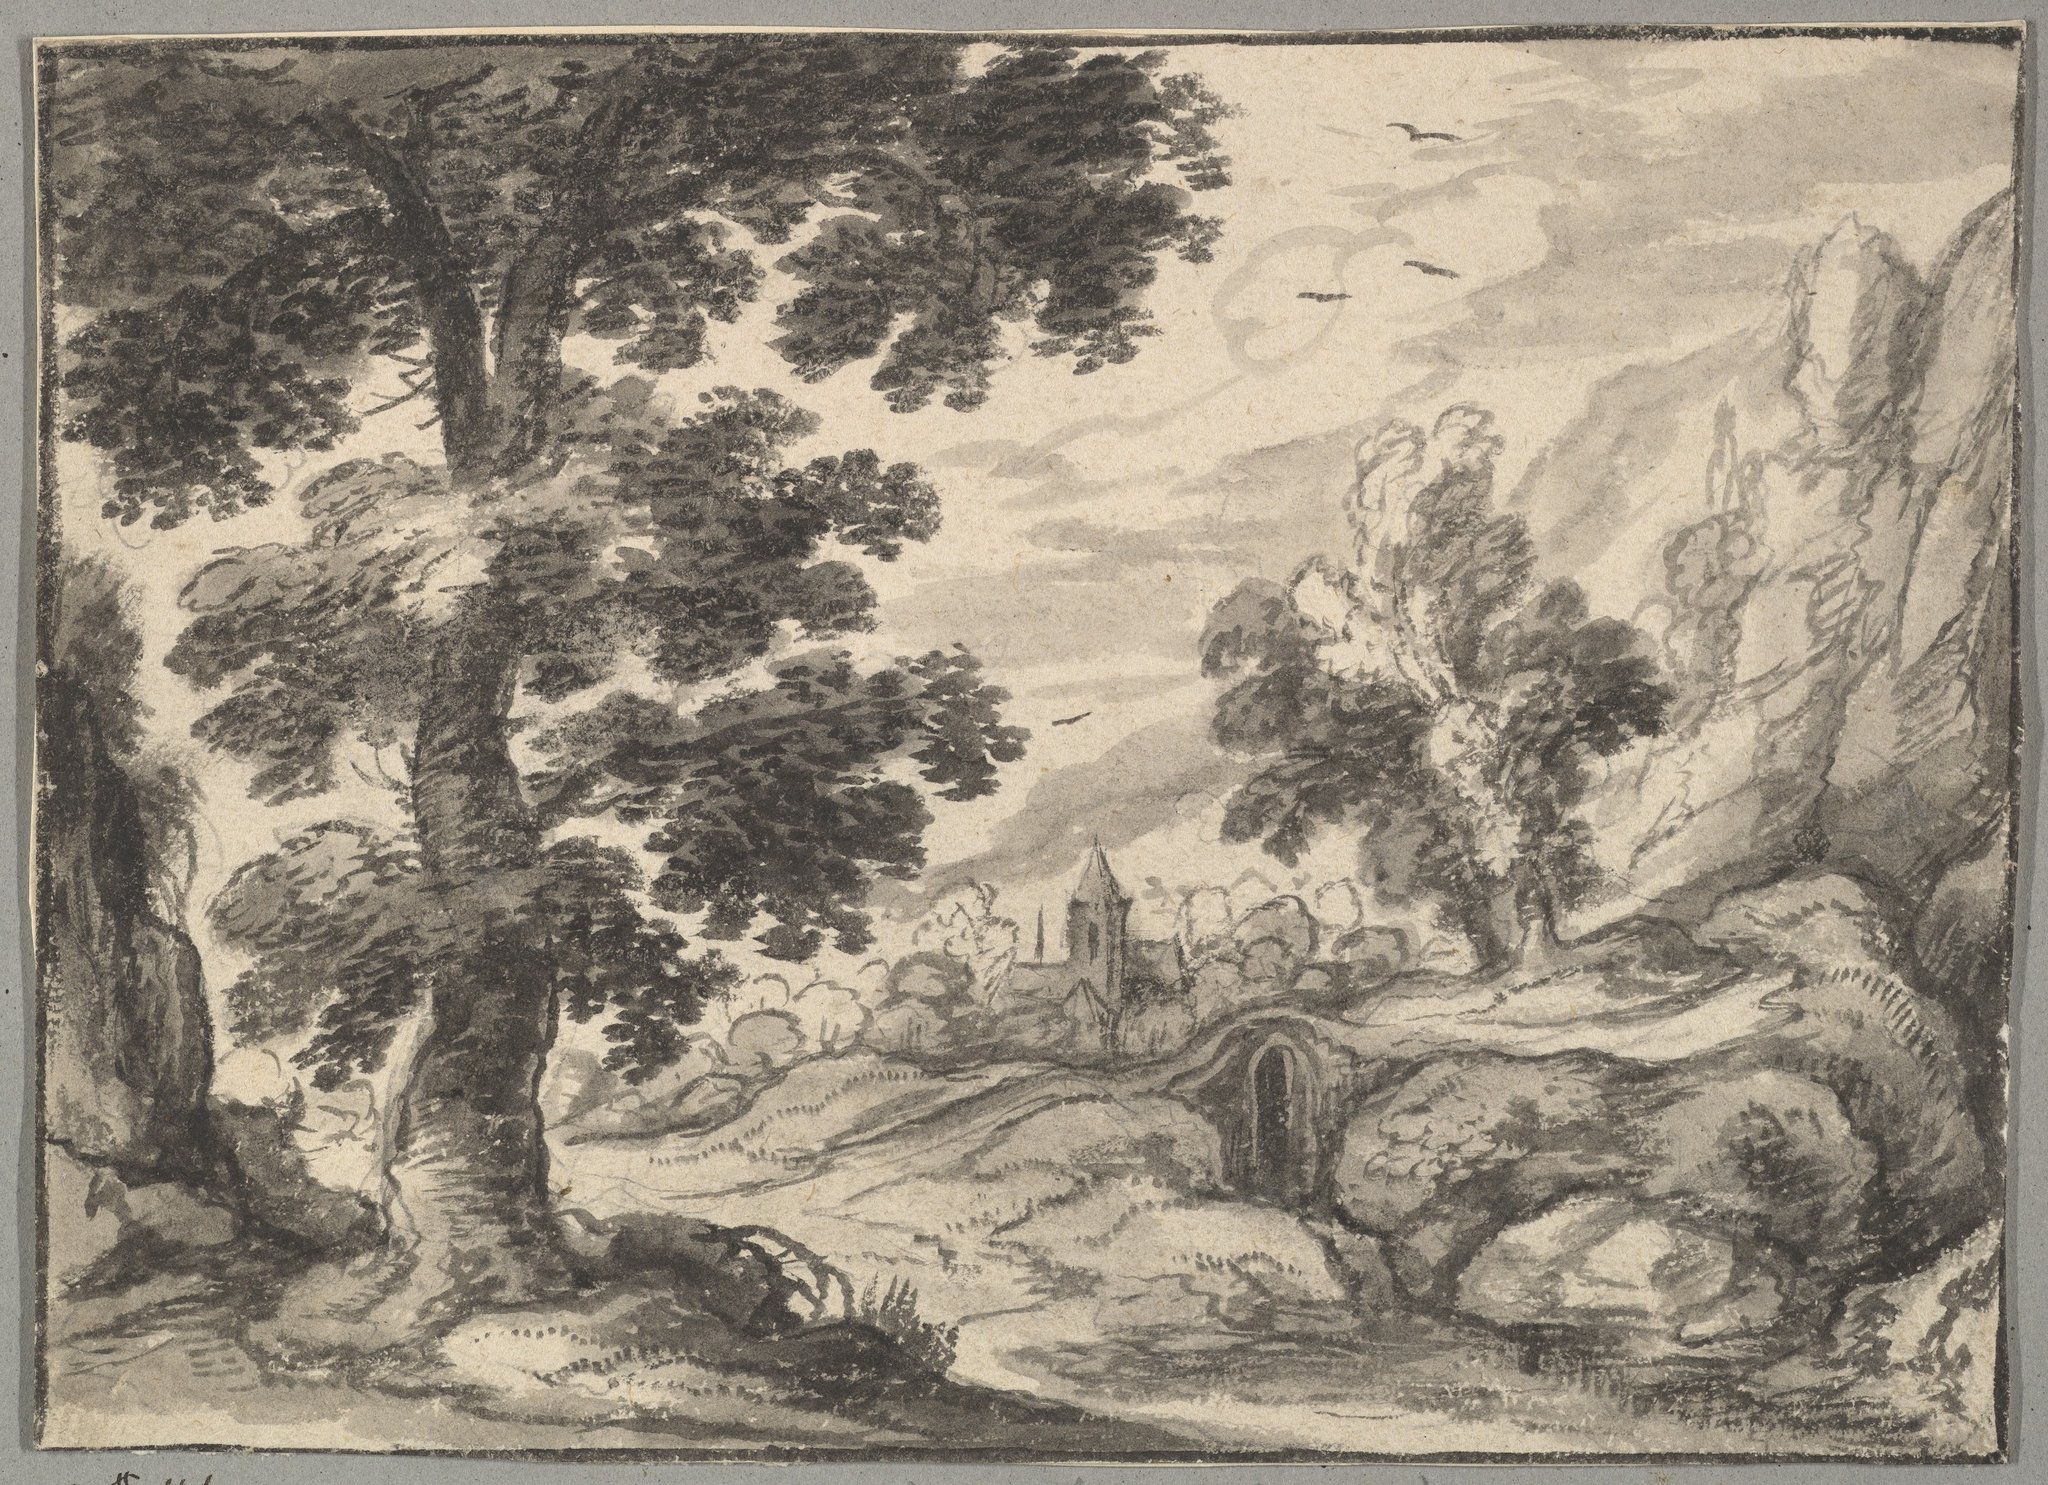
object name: drawing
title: Landscape with a Bridge and a Village Church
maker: anonymous, flemish, 17th century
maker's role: artist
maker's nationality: flemish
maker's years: 1600-1700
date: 1600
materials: chalk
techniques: brush, wash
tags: bridges,churches,landscapes,trees